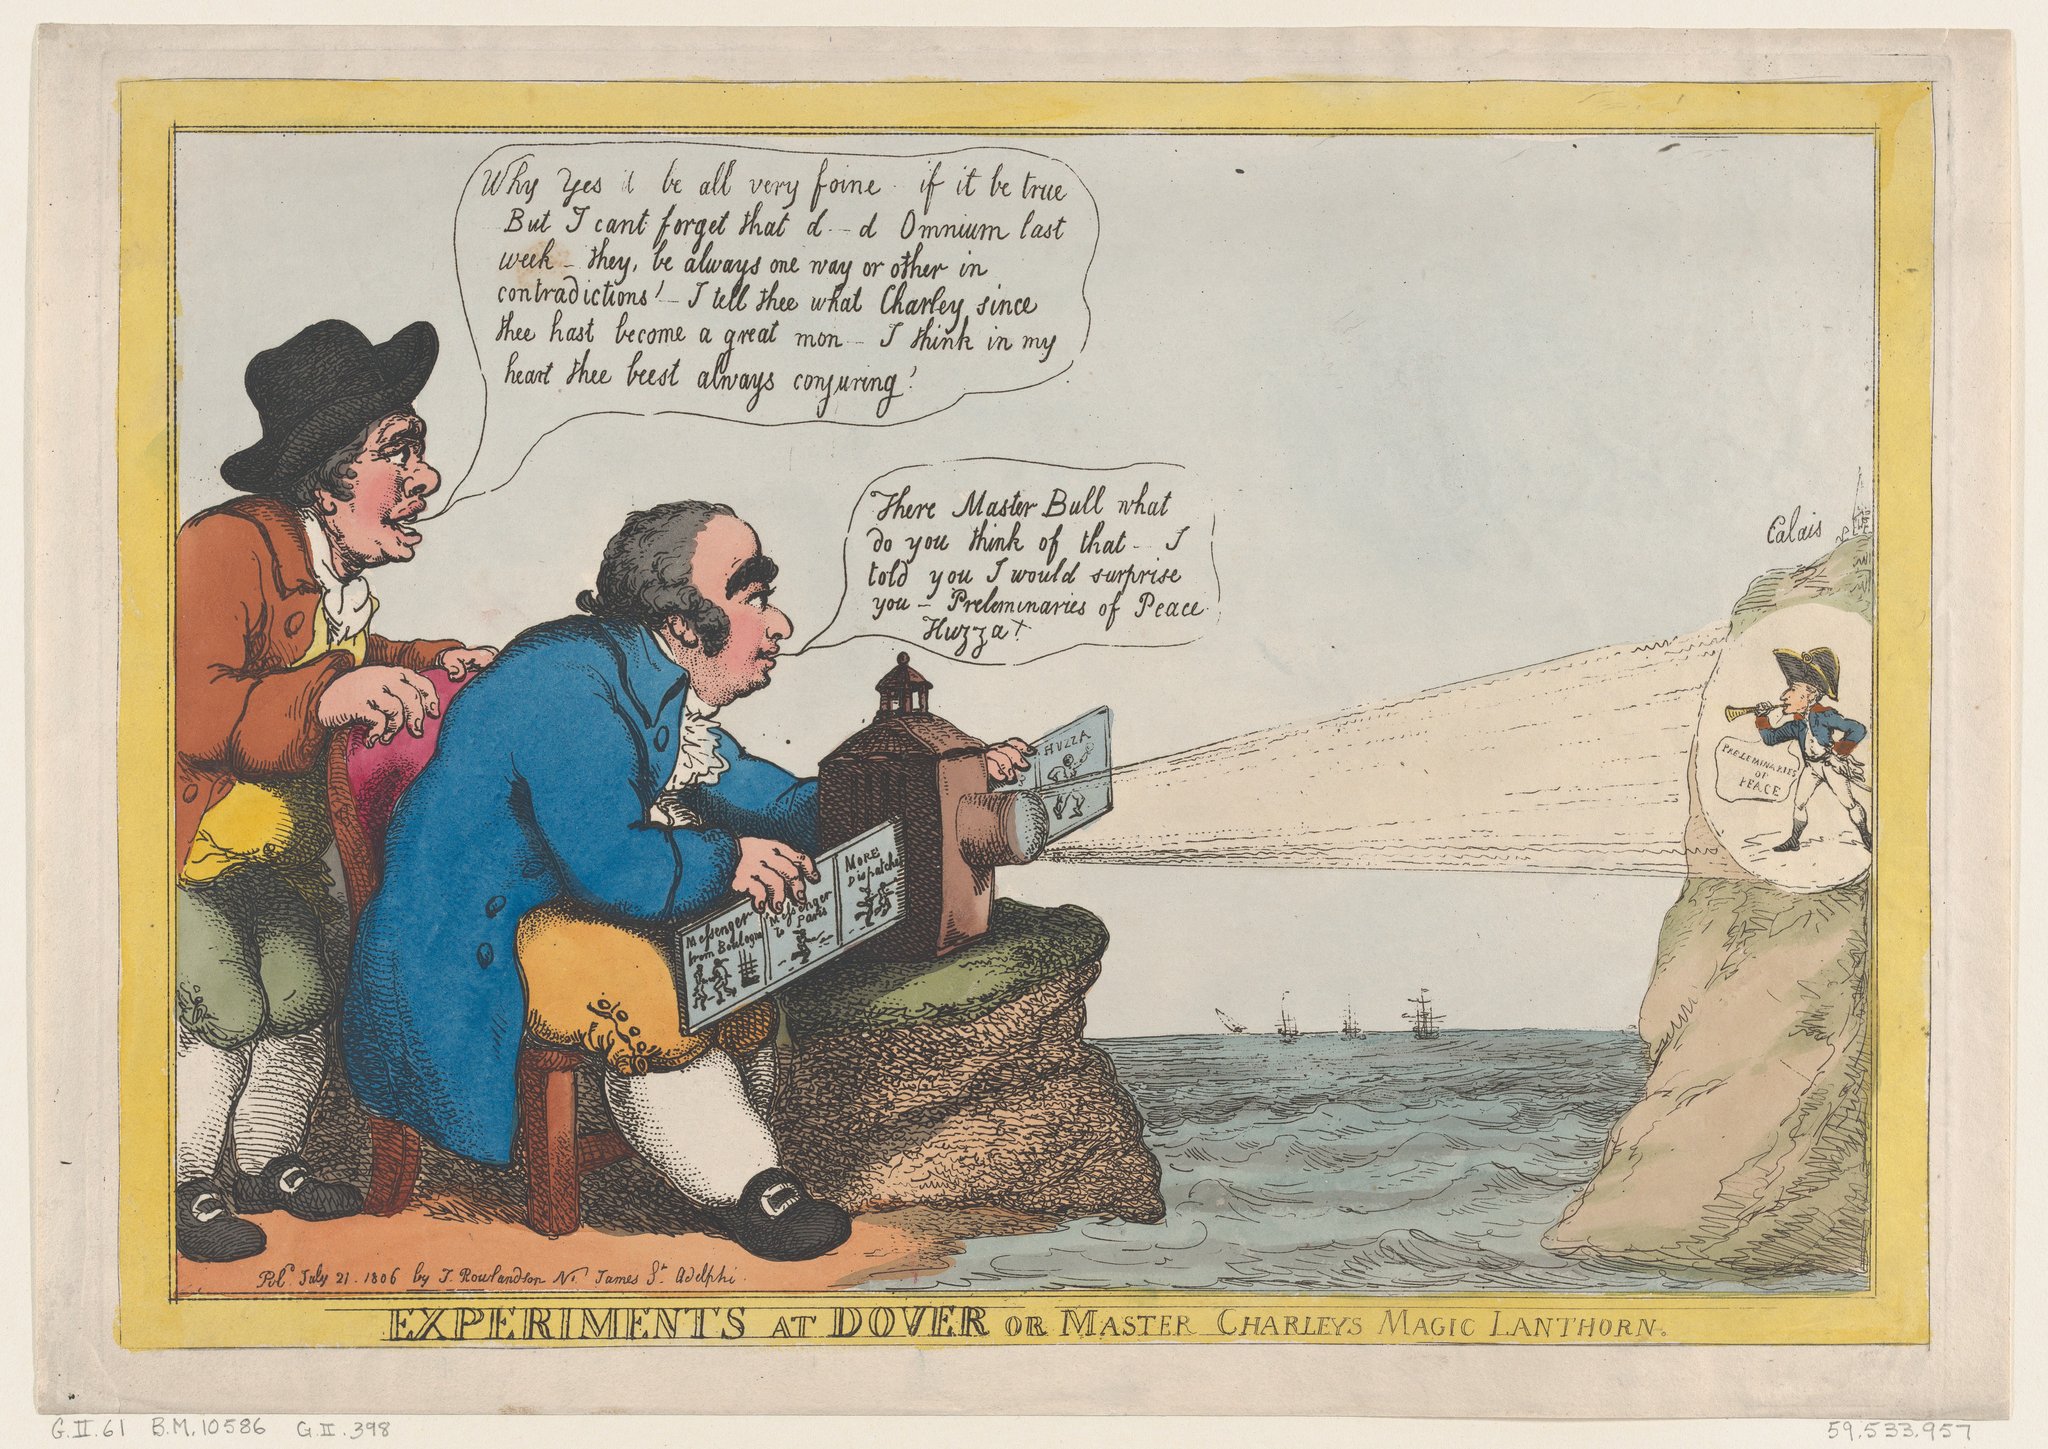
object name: print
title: Experiments at Dover or Master Charley's Magic Lanthorn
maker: thomas rowlandson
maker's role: artist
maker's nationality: british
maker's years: 1757-1827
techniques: etching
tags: satire,napoleon i,men,politics